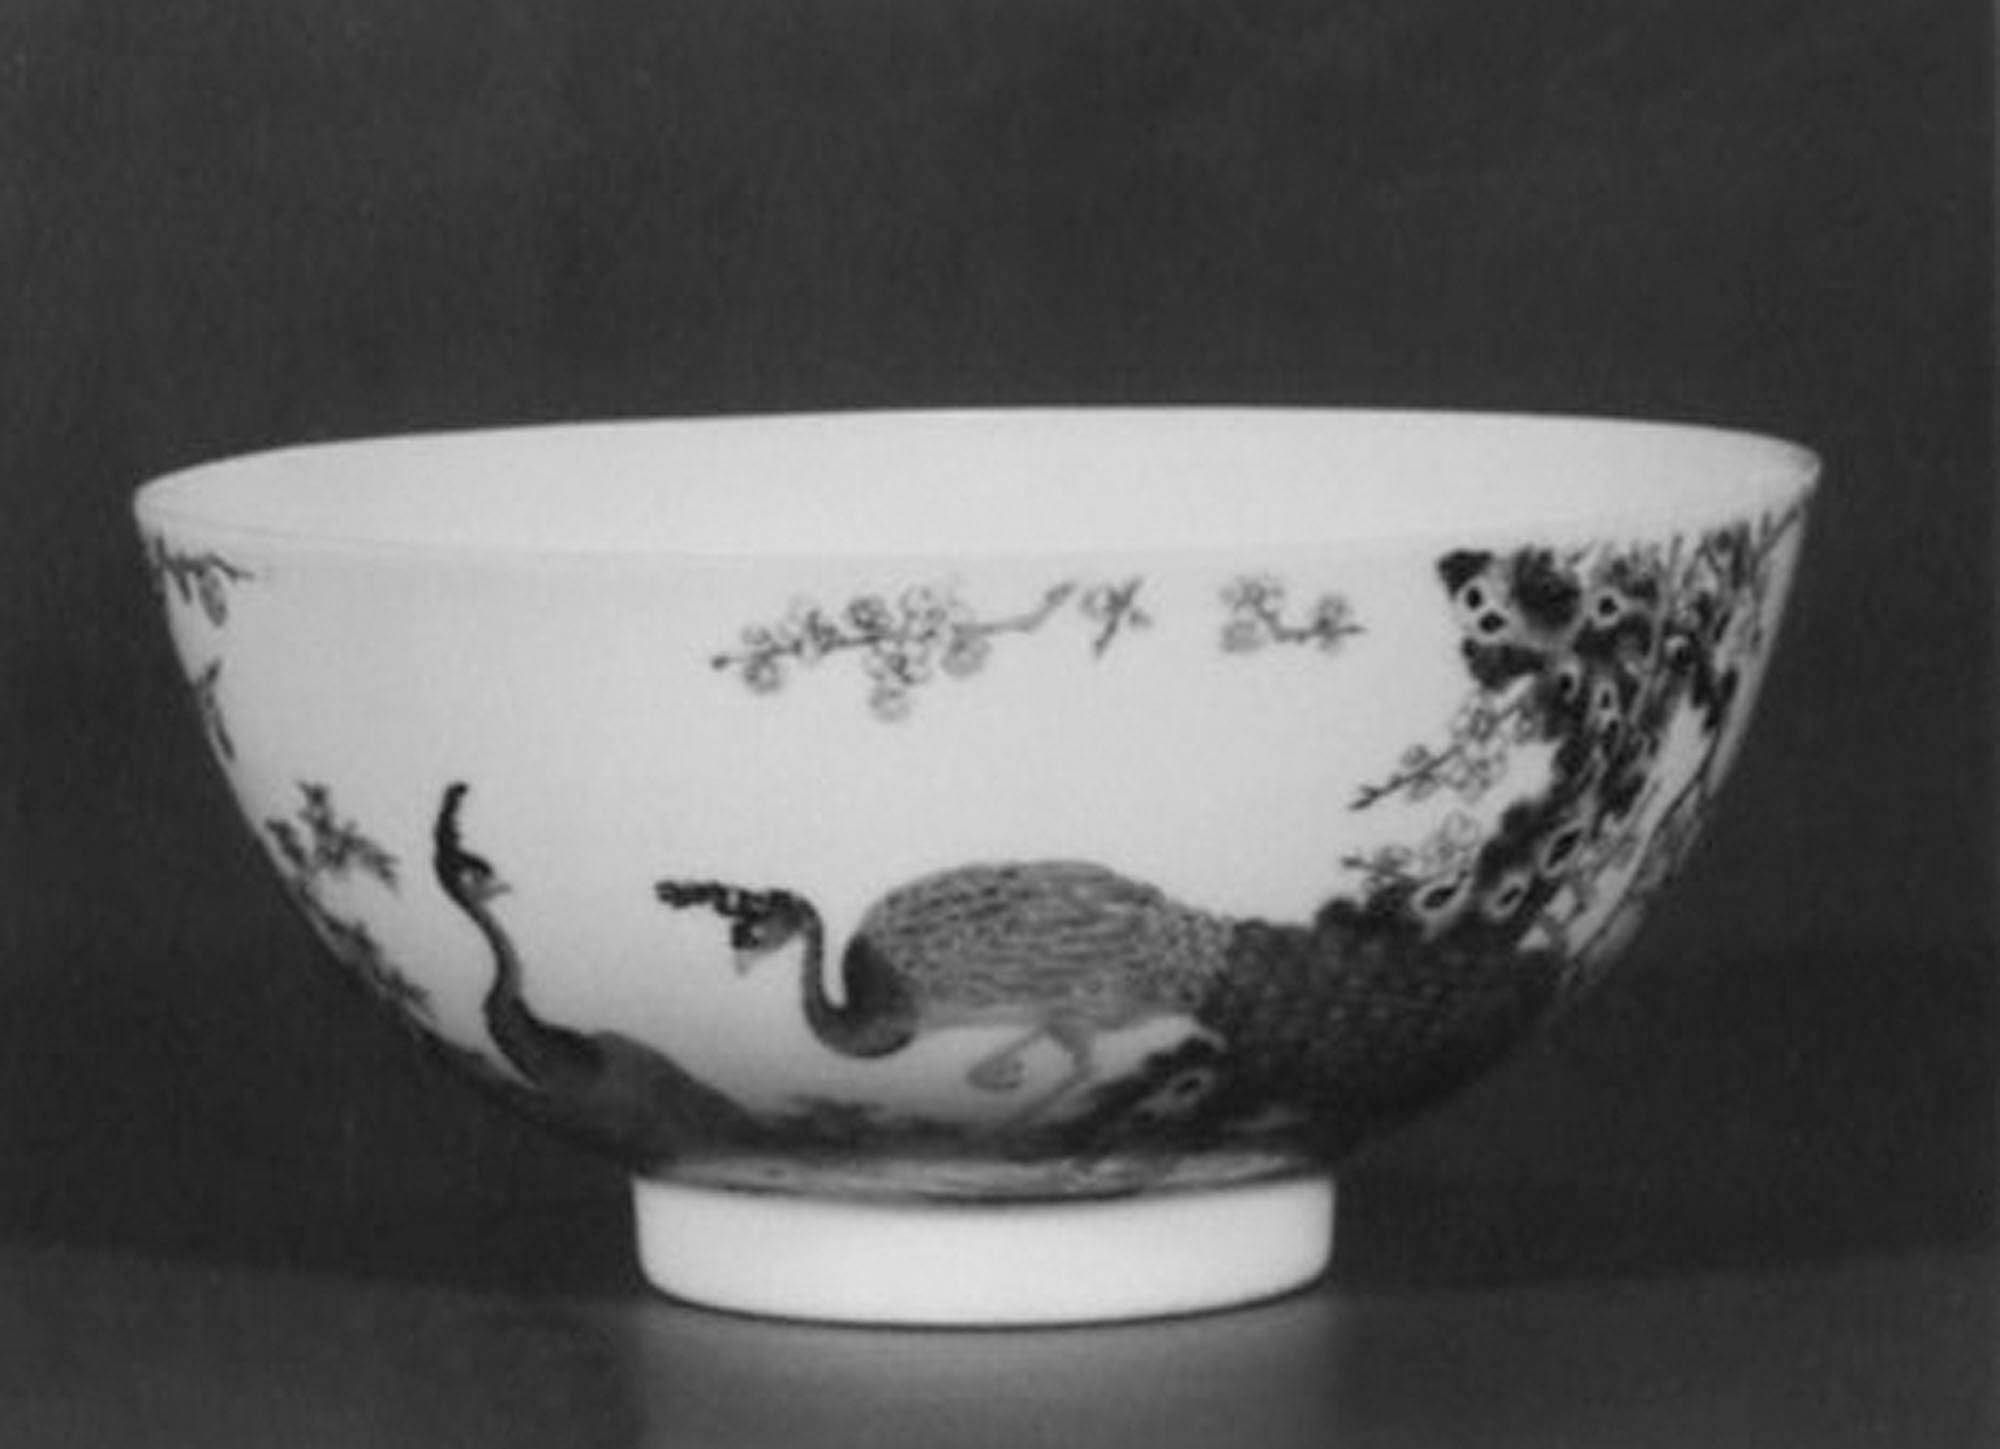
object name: bowl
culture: chinese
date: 1801-1833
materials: enamel, porcelain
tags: peacocks,flowers